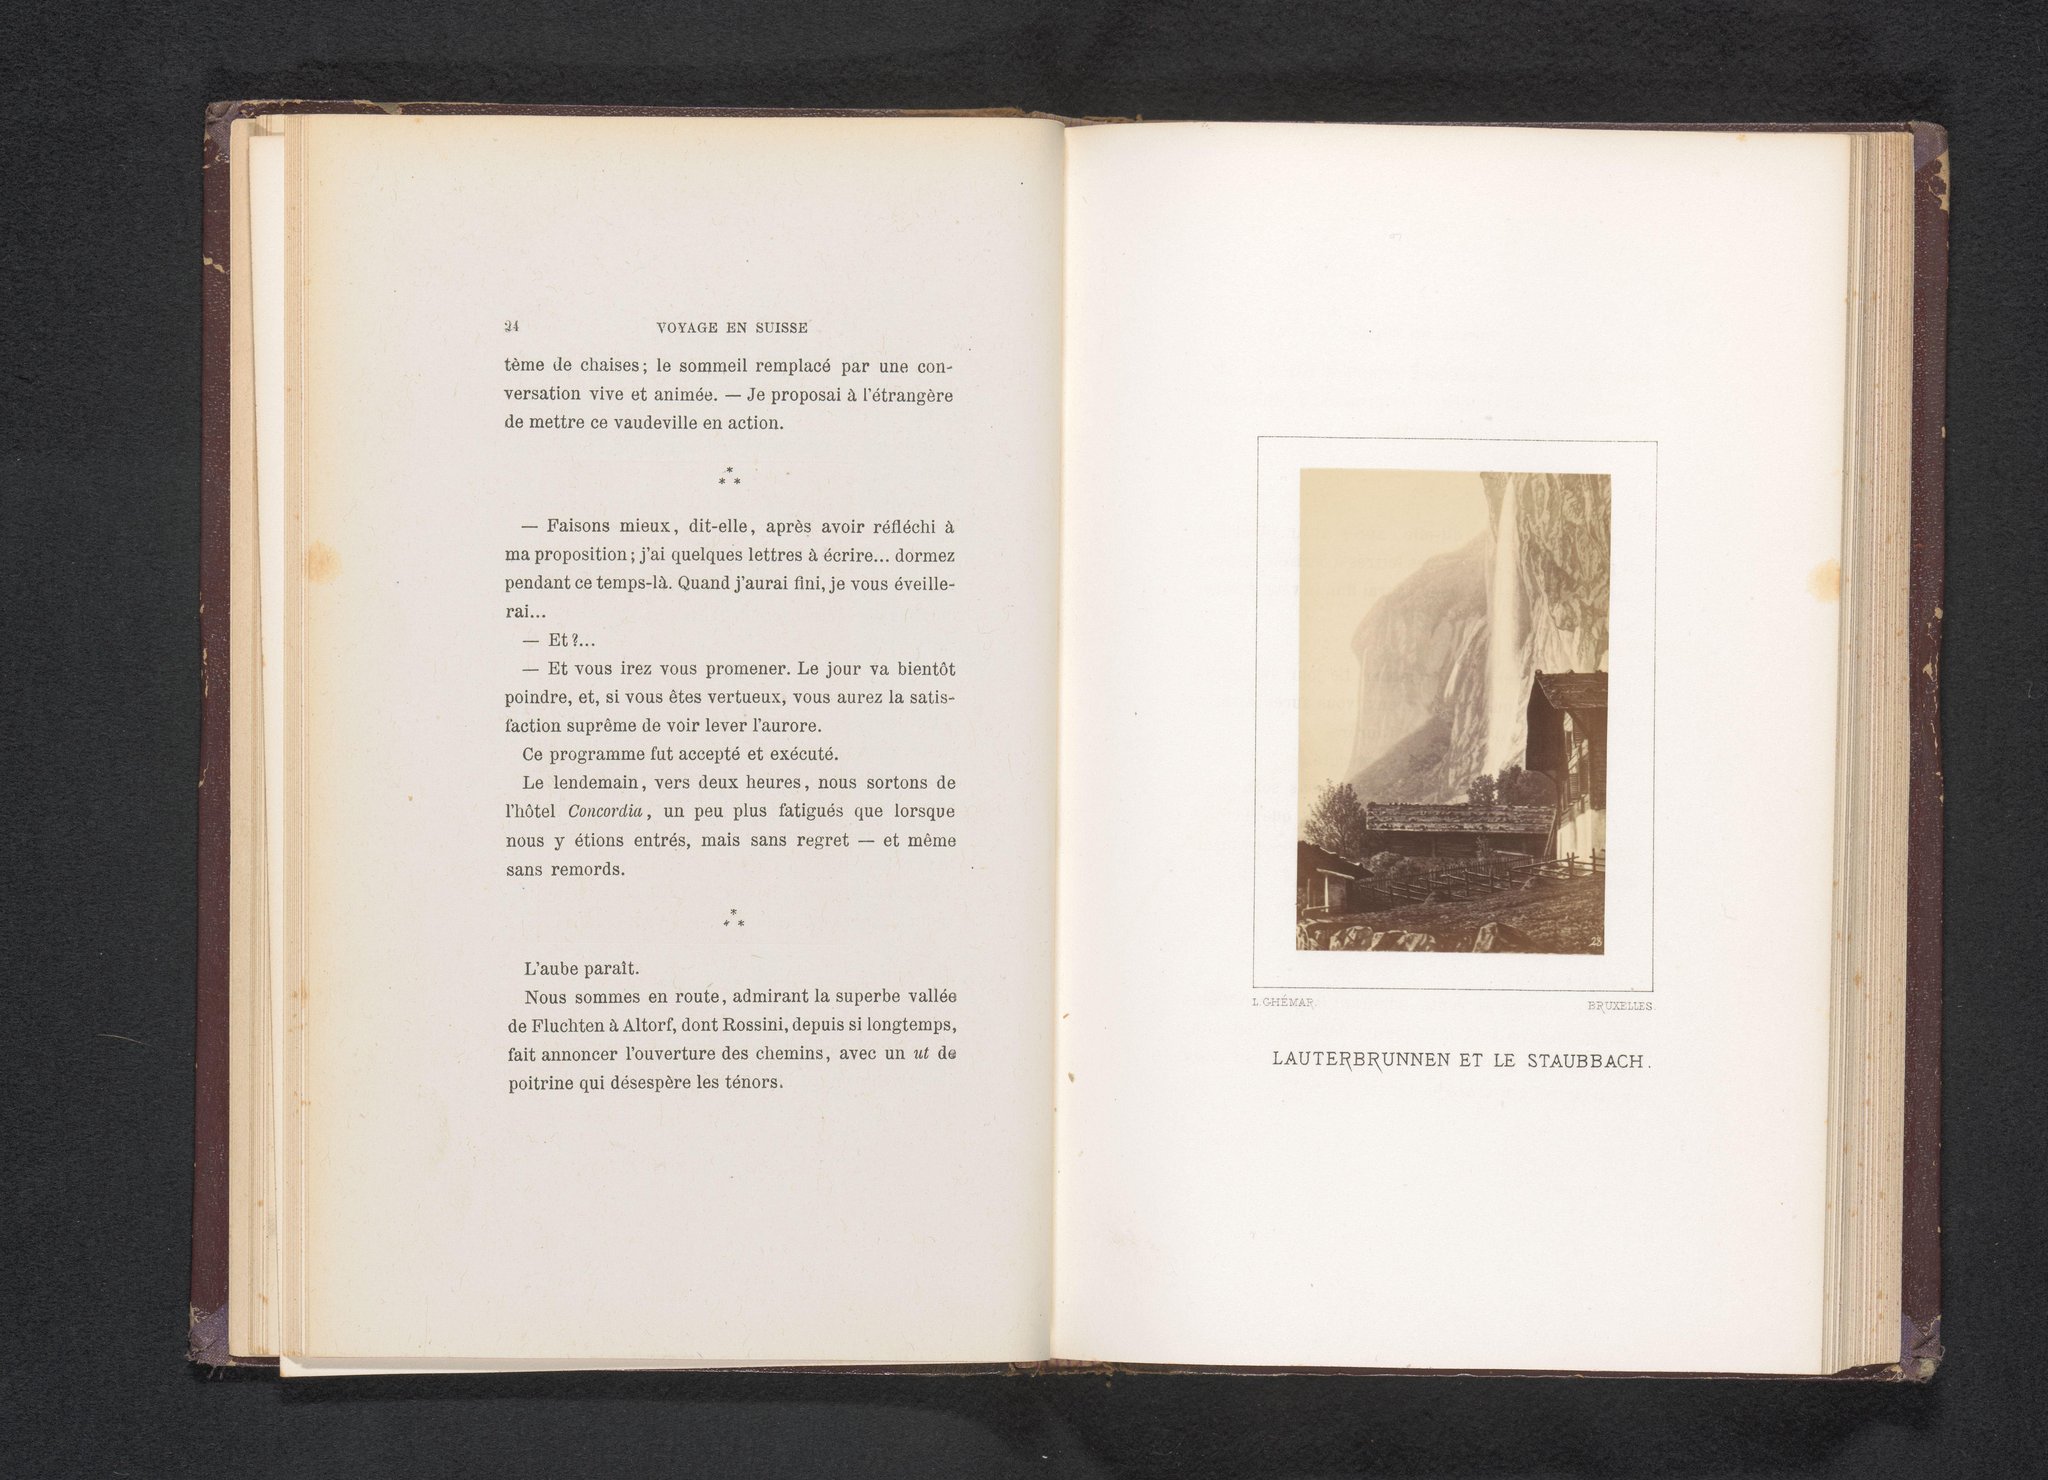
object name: page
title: Gezicht op Lauterbrunnen en de Staubbachwaterval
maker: louis ghémar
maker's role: draughtsman, print maker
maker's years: 1819-1873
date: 1863-1868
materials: photographic support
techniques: albumen print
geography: lauterbrunnen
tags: city-view in general; 'veduta', waterfall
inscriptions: inscription: ‘Bruxelles’, number: ‘28’